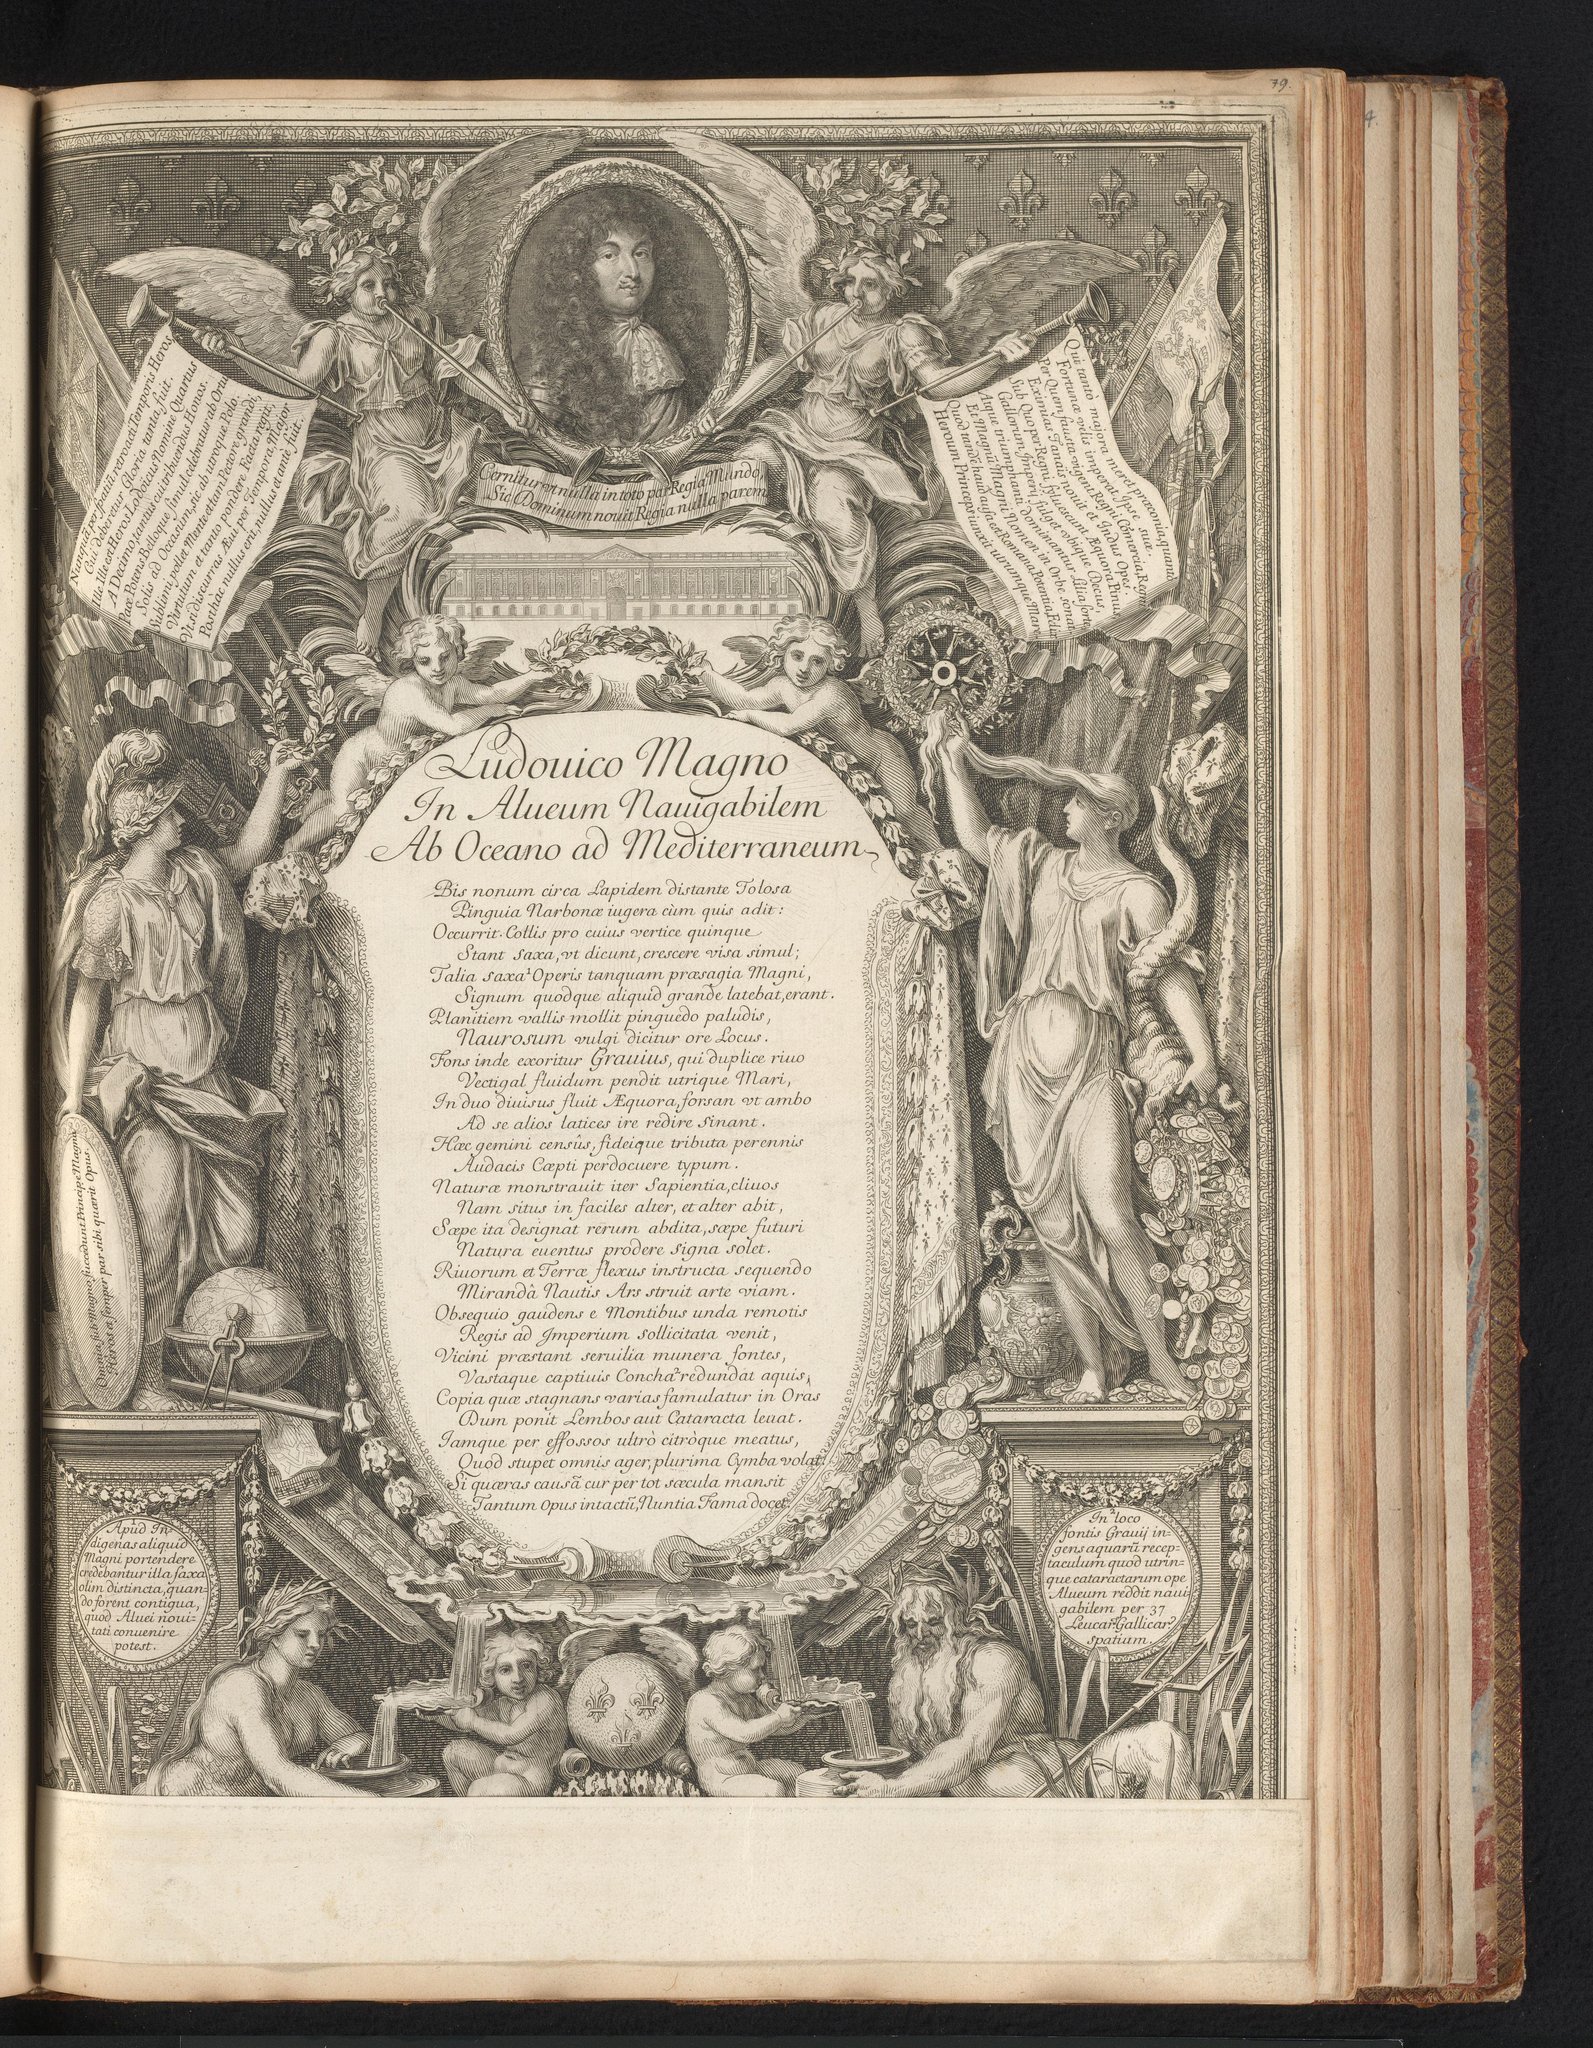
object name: album leaf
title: Allegorie op Lodewijk XIV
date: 1677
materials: paper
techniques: engraving, etching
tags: lodewijk xiv (koning van frankrijk), river personified, 'fiumi' (ripa), historical persons, canal, fame; 'fama', 'fama buona', 'fama chiara' (ripa)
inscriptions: date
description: Aangeboden aan de koning ter gelegenheid van de aanleg van het Canal du Midi door de Languedoc, waardoor twee zeeën met elkaar verbonden werden. Onder de beeltenis van de koning een gezicht op de façade van het Louvre. Prent maakt deel uit van een album.